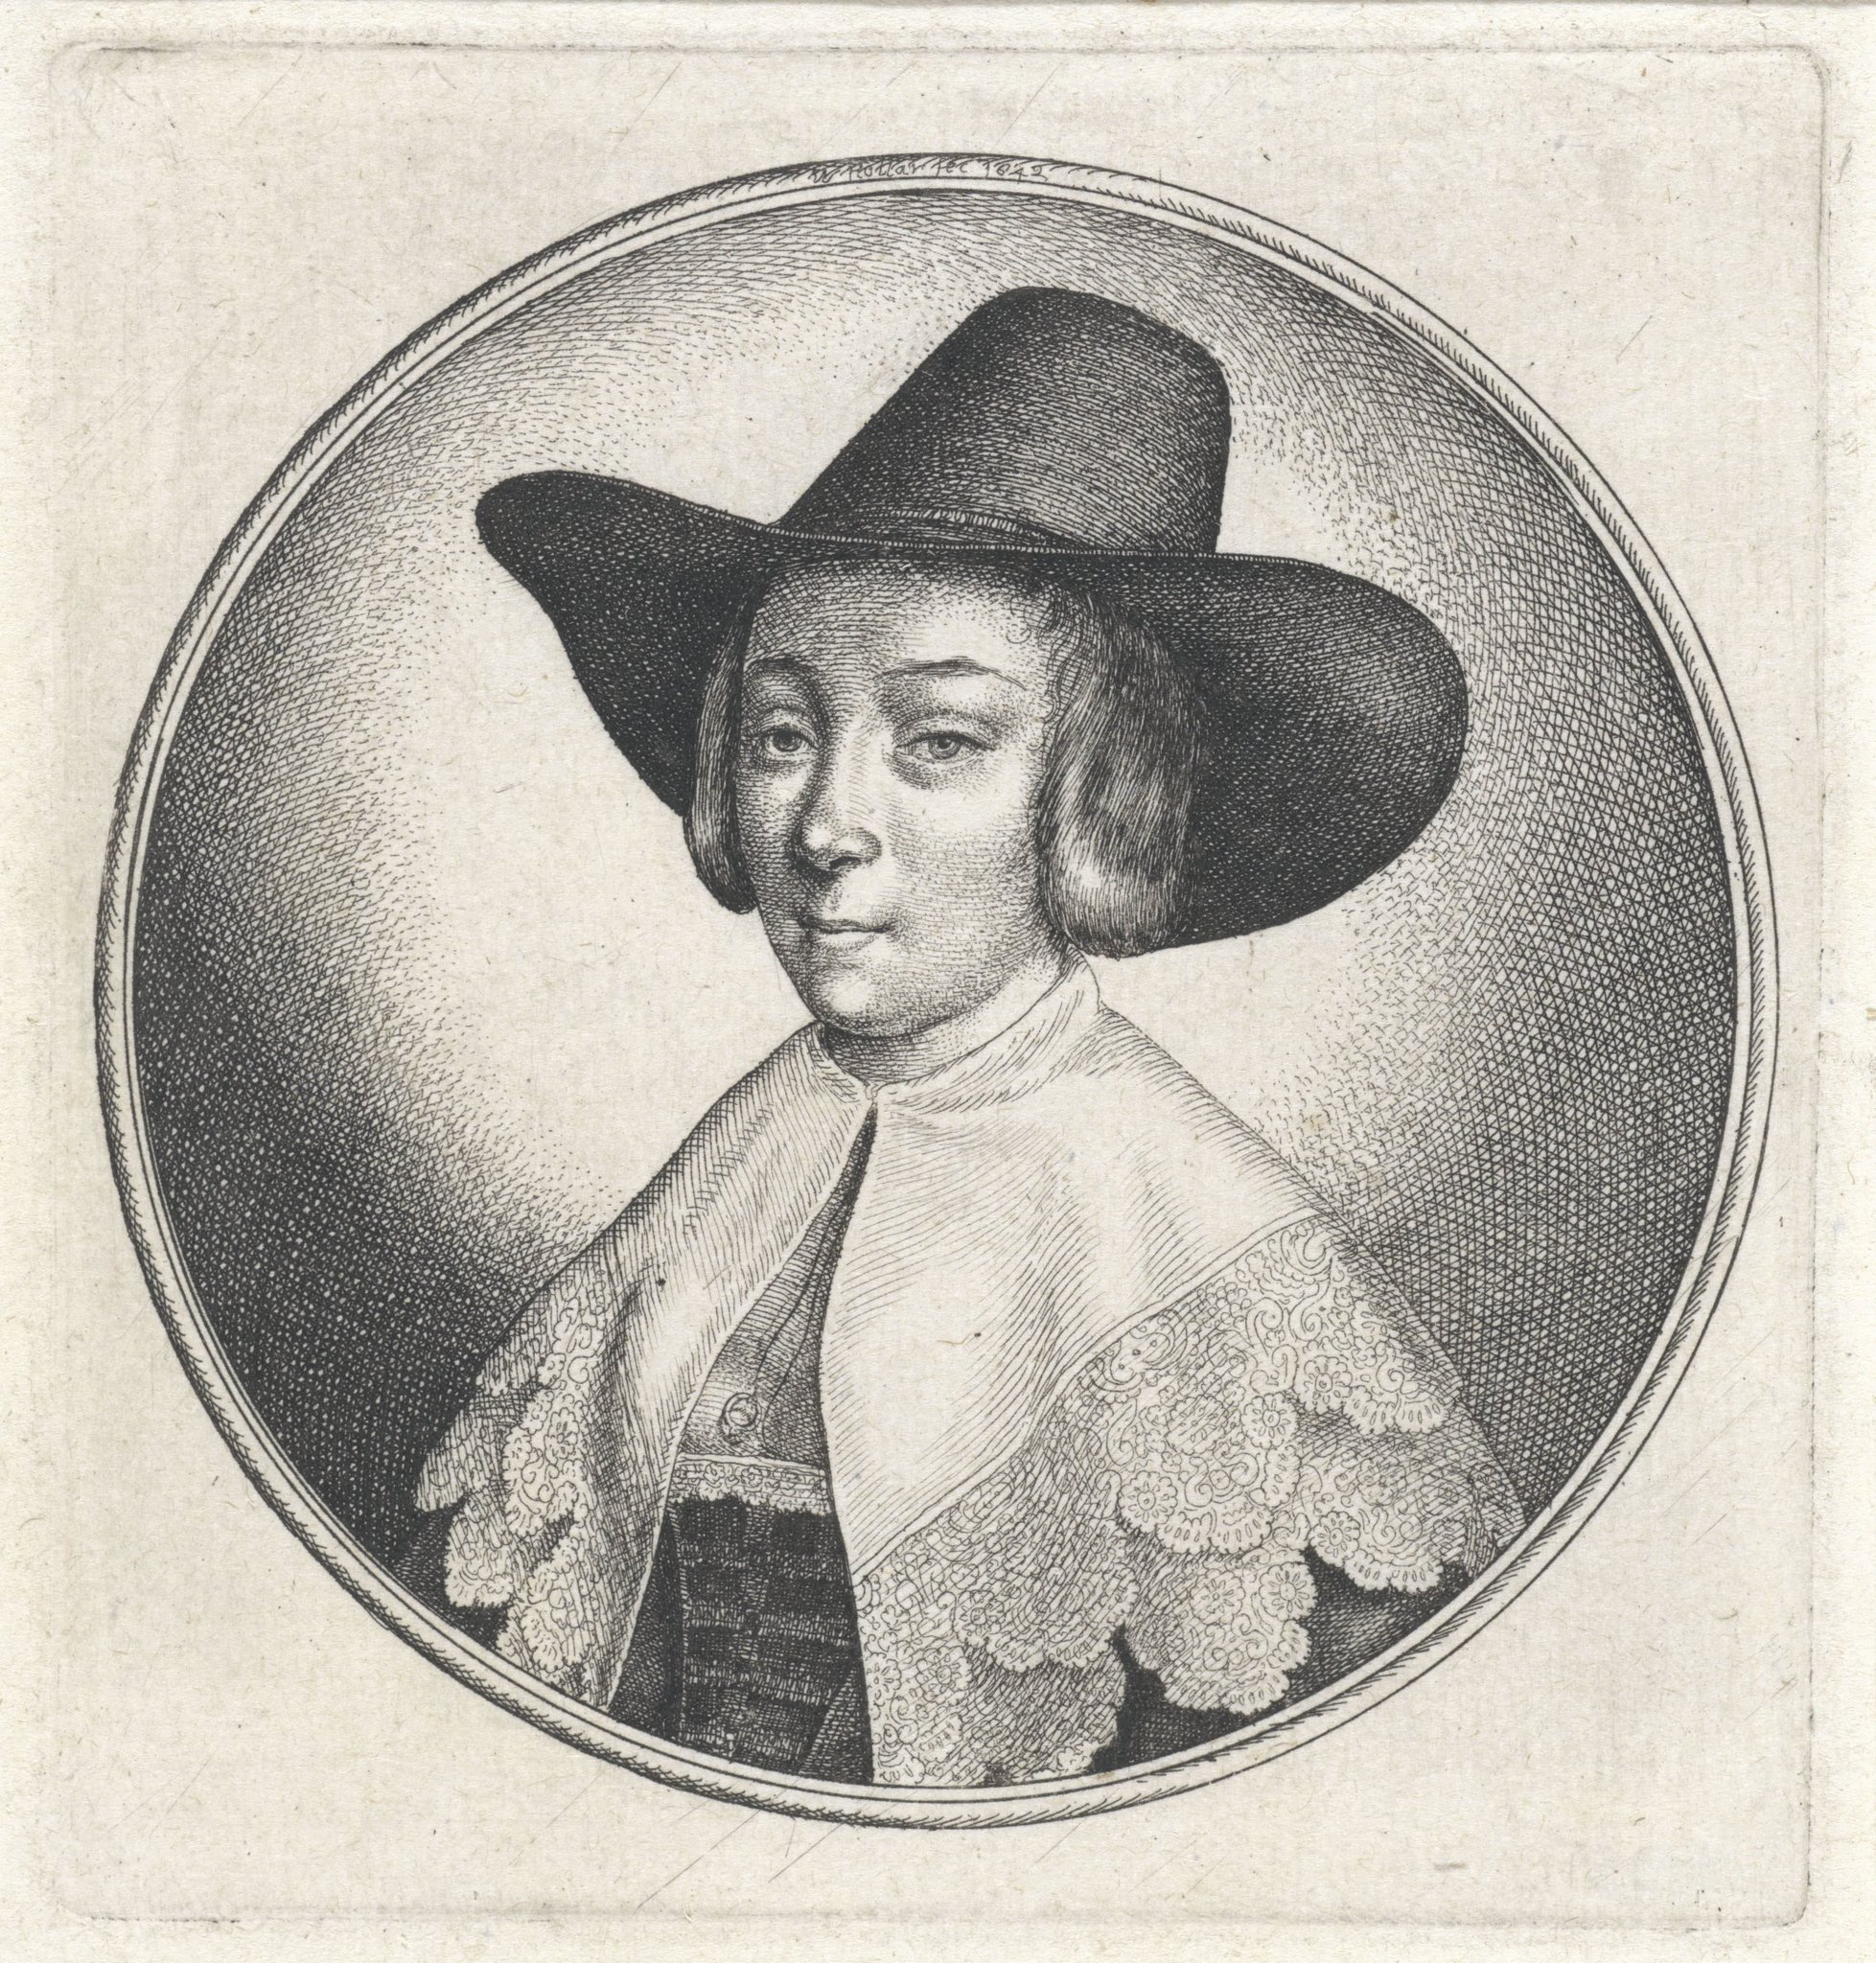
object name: print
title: Medaillons met vrouwenbusten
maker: wenceslaus hollar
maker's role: draughtsman, print maker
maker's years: 1607-1677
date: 1642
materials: paper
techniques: etching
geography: london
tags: head-gear: hat (+ men's clothes), anonymous historical person portrayed alone - bb - woman, neck-gear: collar (+ women's clothes)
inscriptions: collector's mark: Lugt 654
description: De prent maakt deel uit van een 13-delige serie met vrouwenbusten in medaillons.